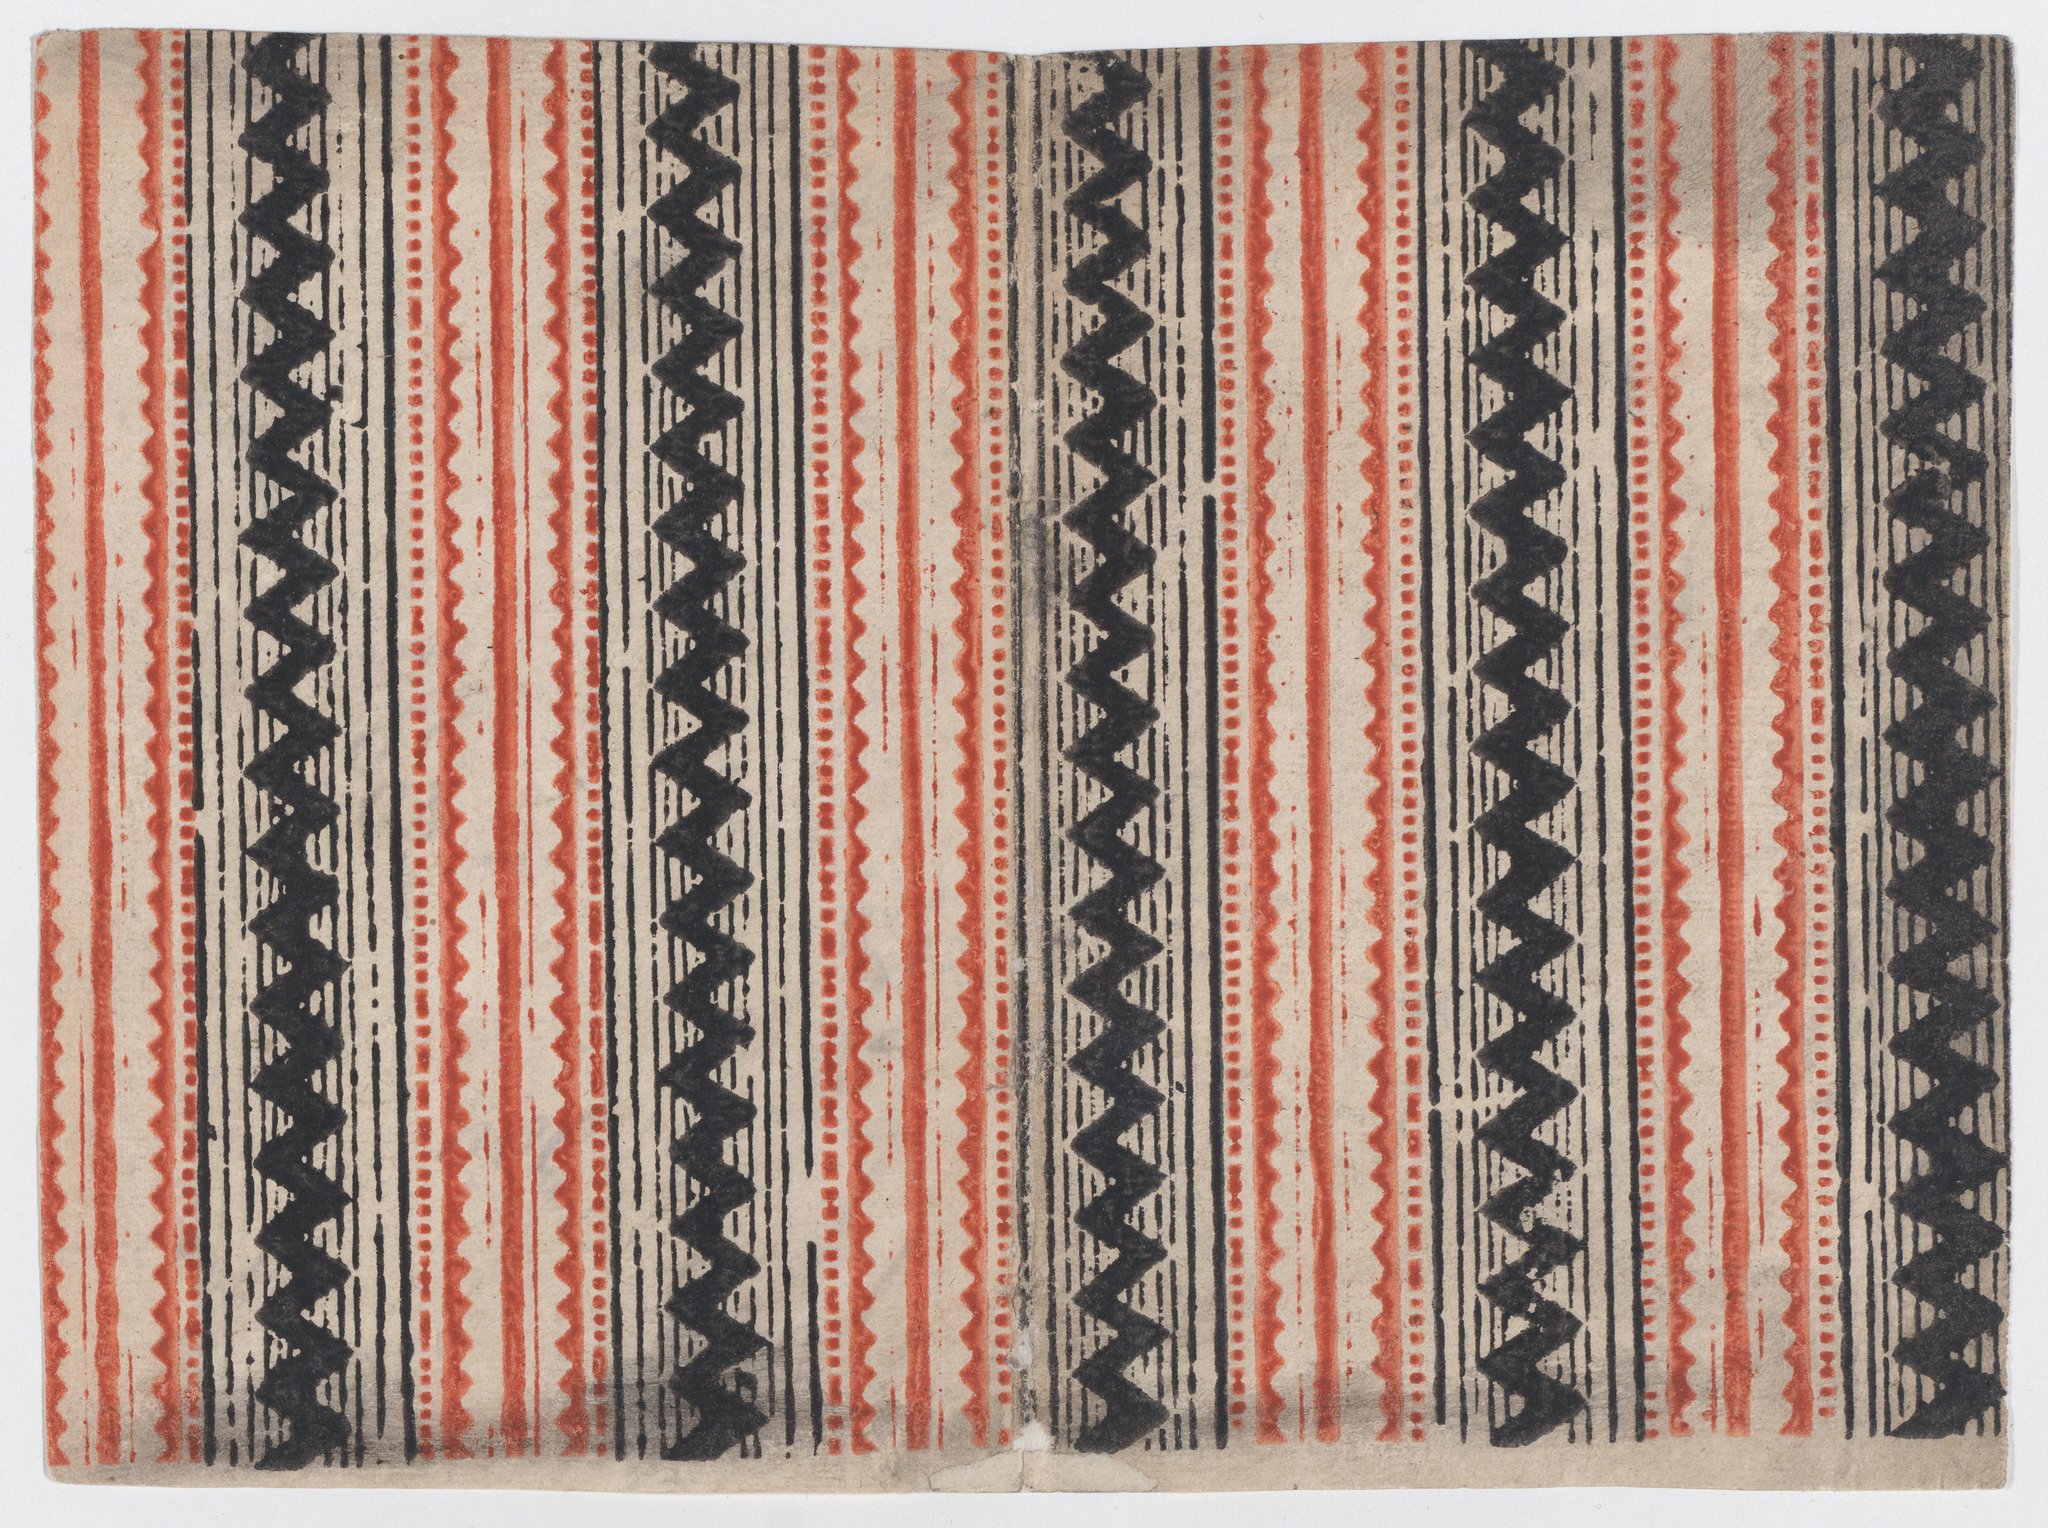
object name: print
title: Sheet with overall zig zag and stripe pattern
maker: Anonymous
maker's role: artist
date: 1801-1900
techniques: relief print